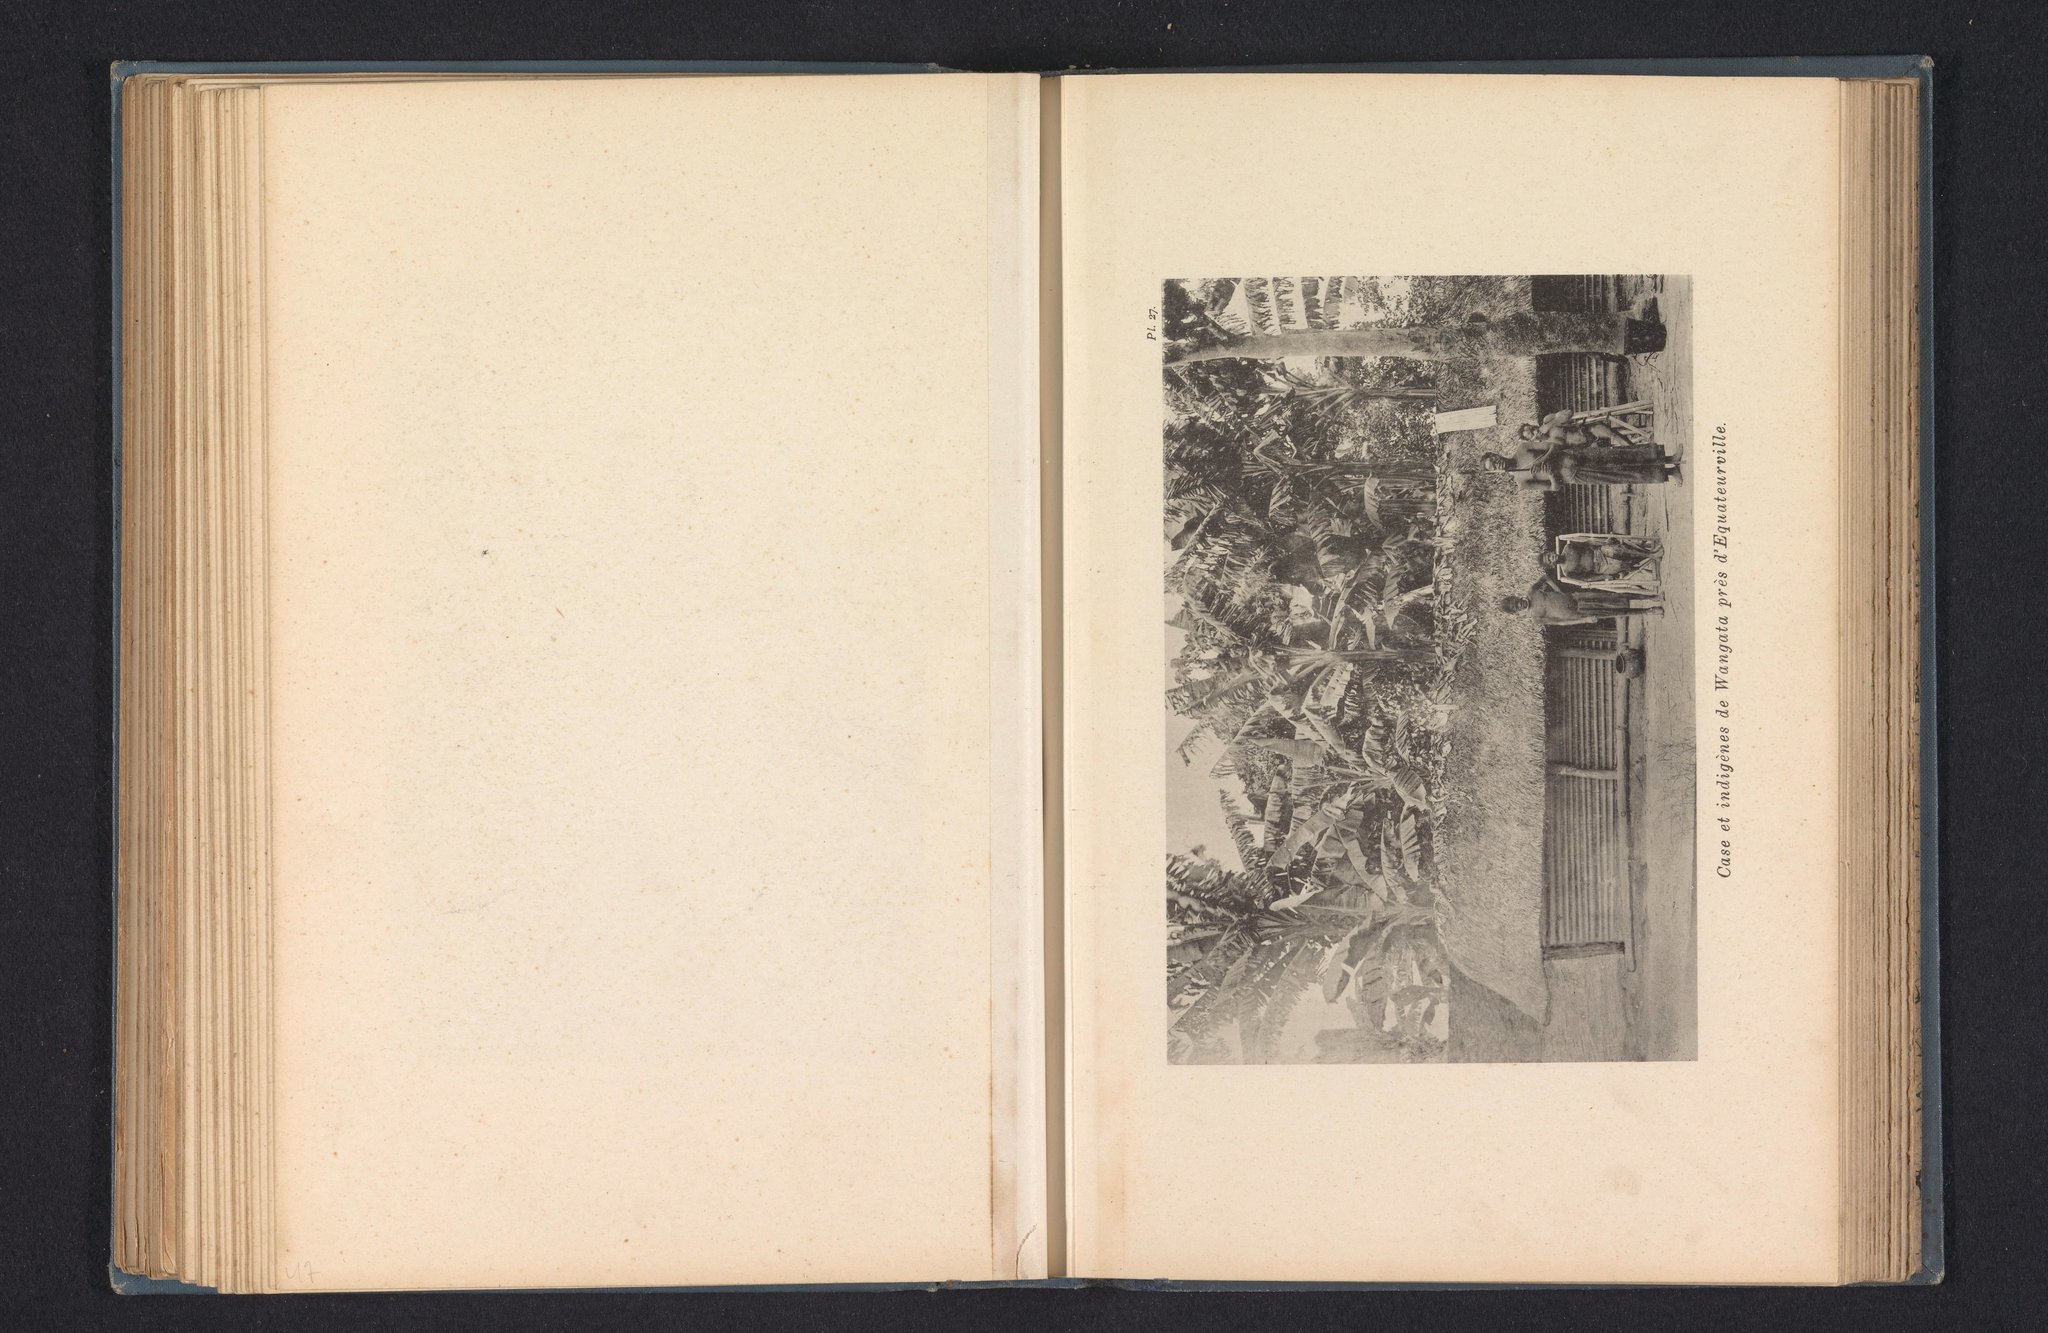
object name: page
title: Case et indigènes de Wangata près d'Equateurville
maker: franz thonner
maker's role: botanicus, ontdekkingsreiziger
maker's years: 1863-1928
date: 1896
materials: paper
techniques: photograph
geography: dresden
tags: family group, especially parents with their child(ren), housing, façade (of house or building)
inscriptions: number: ‘Pl. 27.’